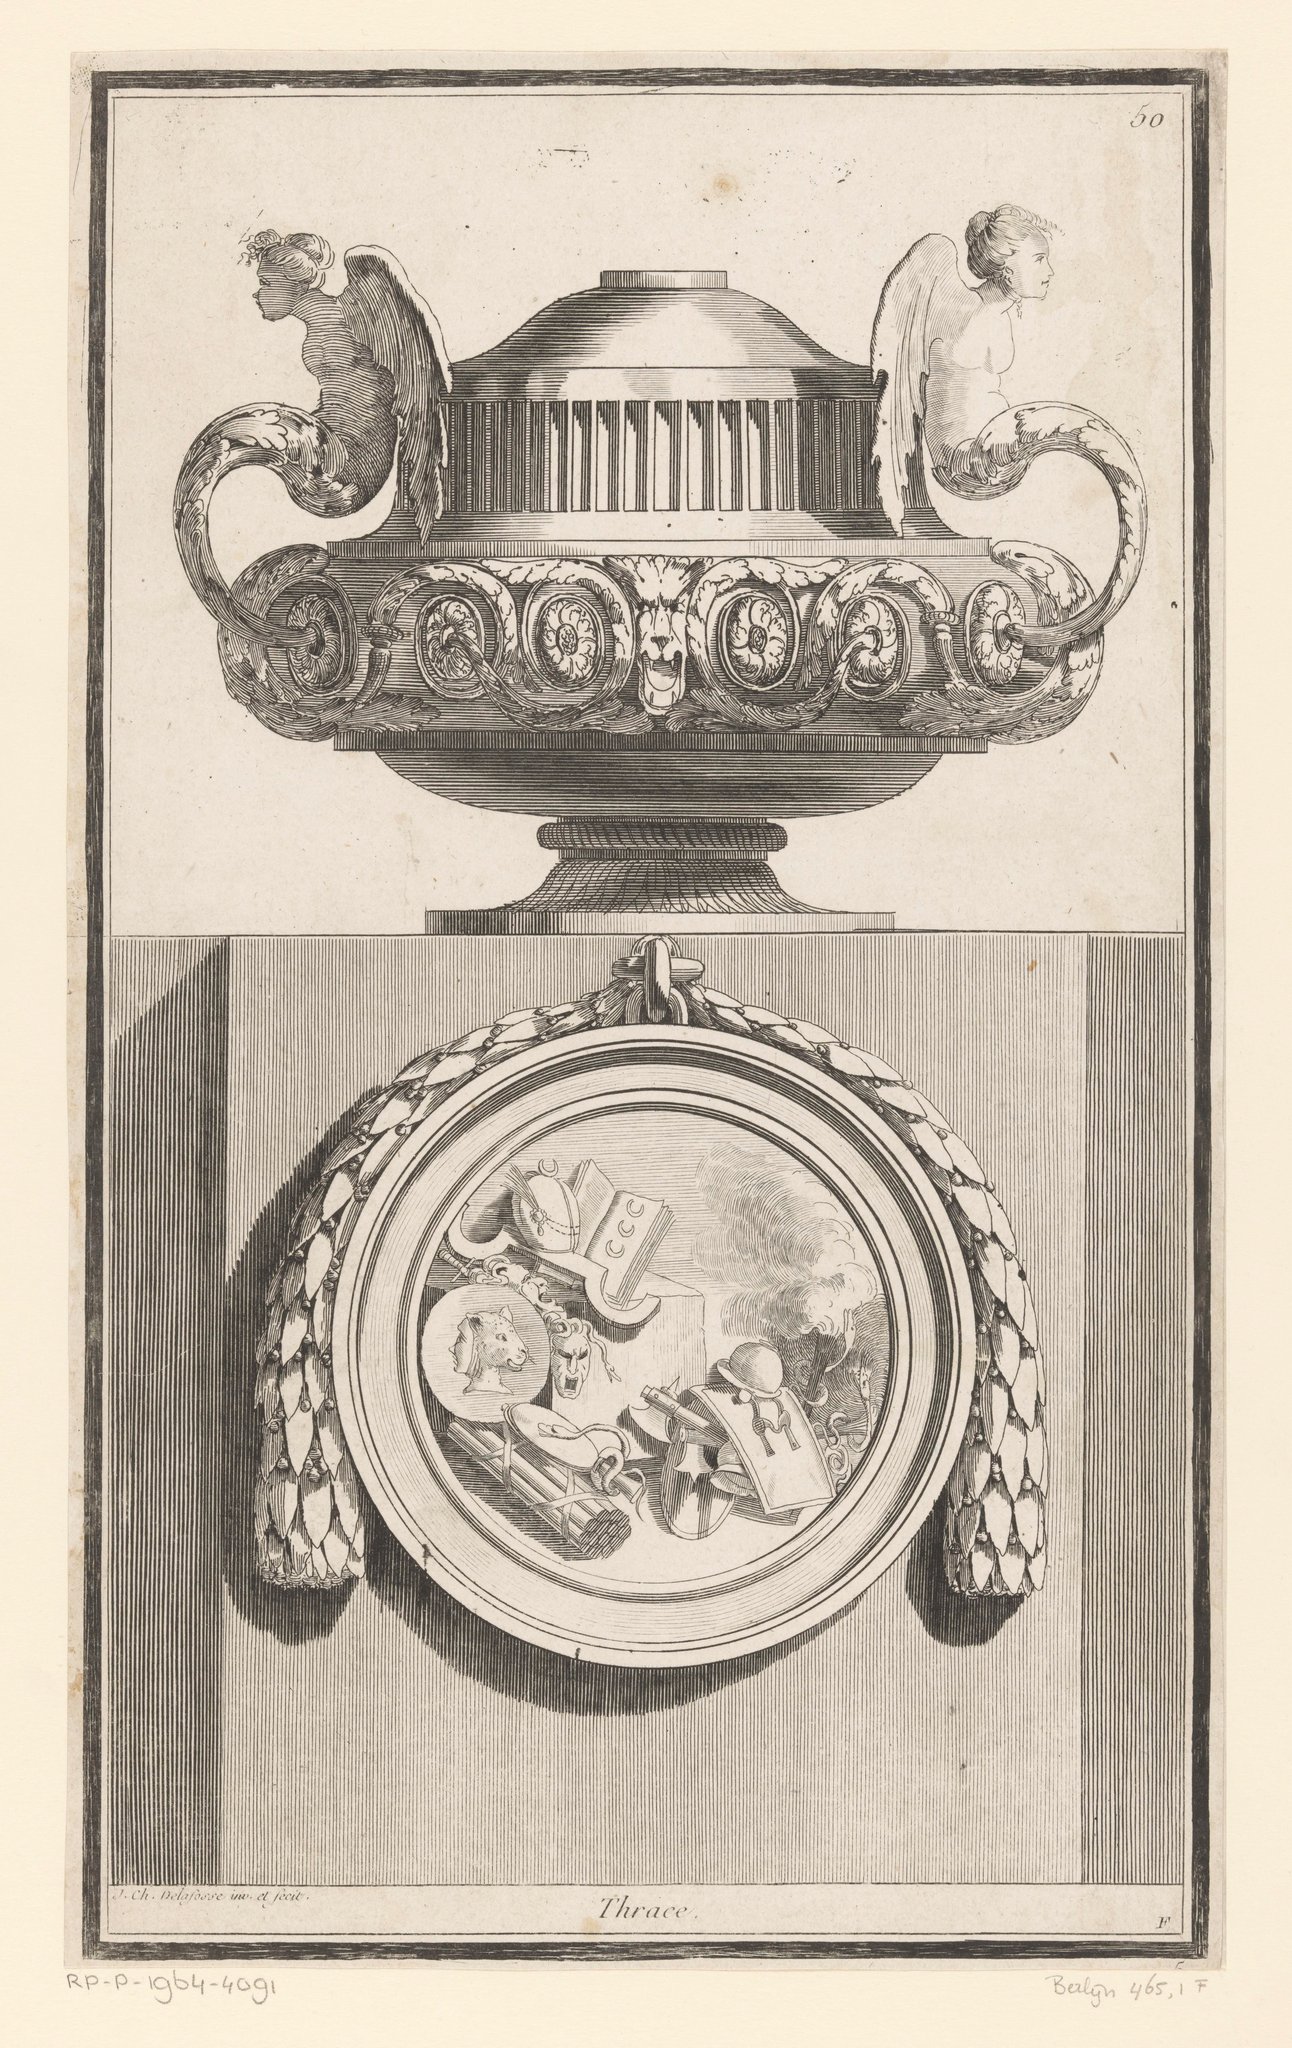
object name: print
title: Thrace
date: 1768-1771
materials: paper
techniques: engraving, etching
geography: paris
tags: vase ~ ornament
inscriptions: collector's mark: Lugt 2760, collector's mark: Lugt 2228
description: Een geornamenteerde vaas met vrouwelijke gevleugelde halffiguren. Daaronder een rond medaillon met een fakkel, slangen, een helm, schilden en wapens. Prentnummer 50.